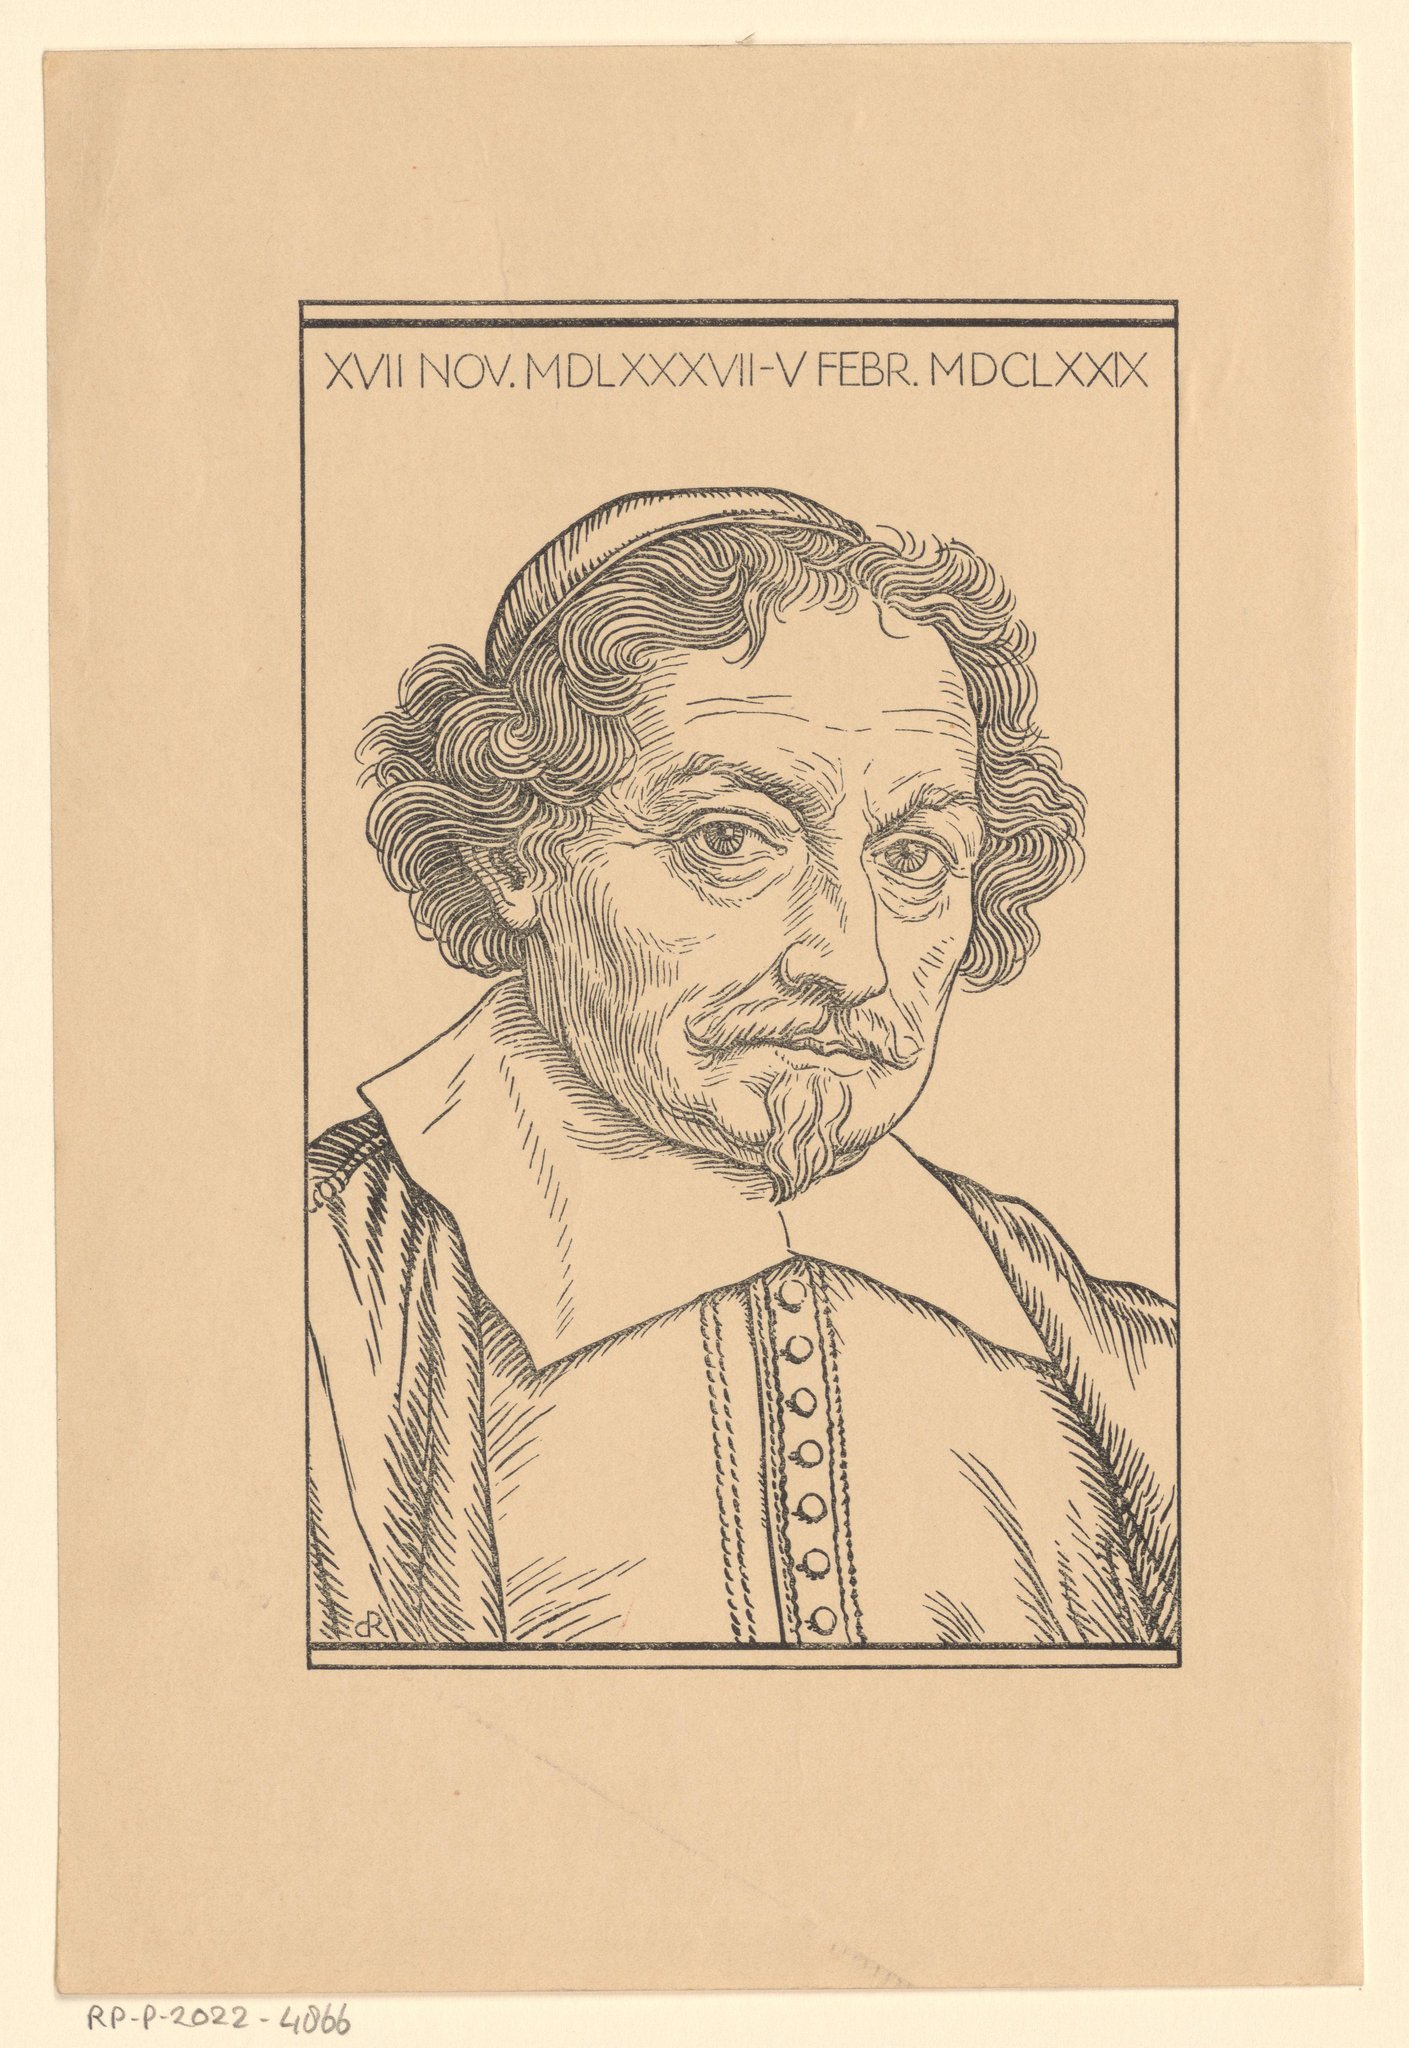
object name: photomechanical print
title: Portret van Joost van den Vondel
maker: Anonymous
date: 1937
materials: paper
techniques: line block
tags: cologne, joost van den vondel, historical persons, portrait of a writer, writer, poet, author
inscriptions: monogram: ‘cR’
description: Fotomechanische afdruk waarschijnlijk uit: Vondel, Joost van den, en Verwey, Albert. Volledige dichtwerken en oorspronkelijk proza (...). Amsterdam: H.J.W. Becht, 1937.